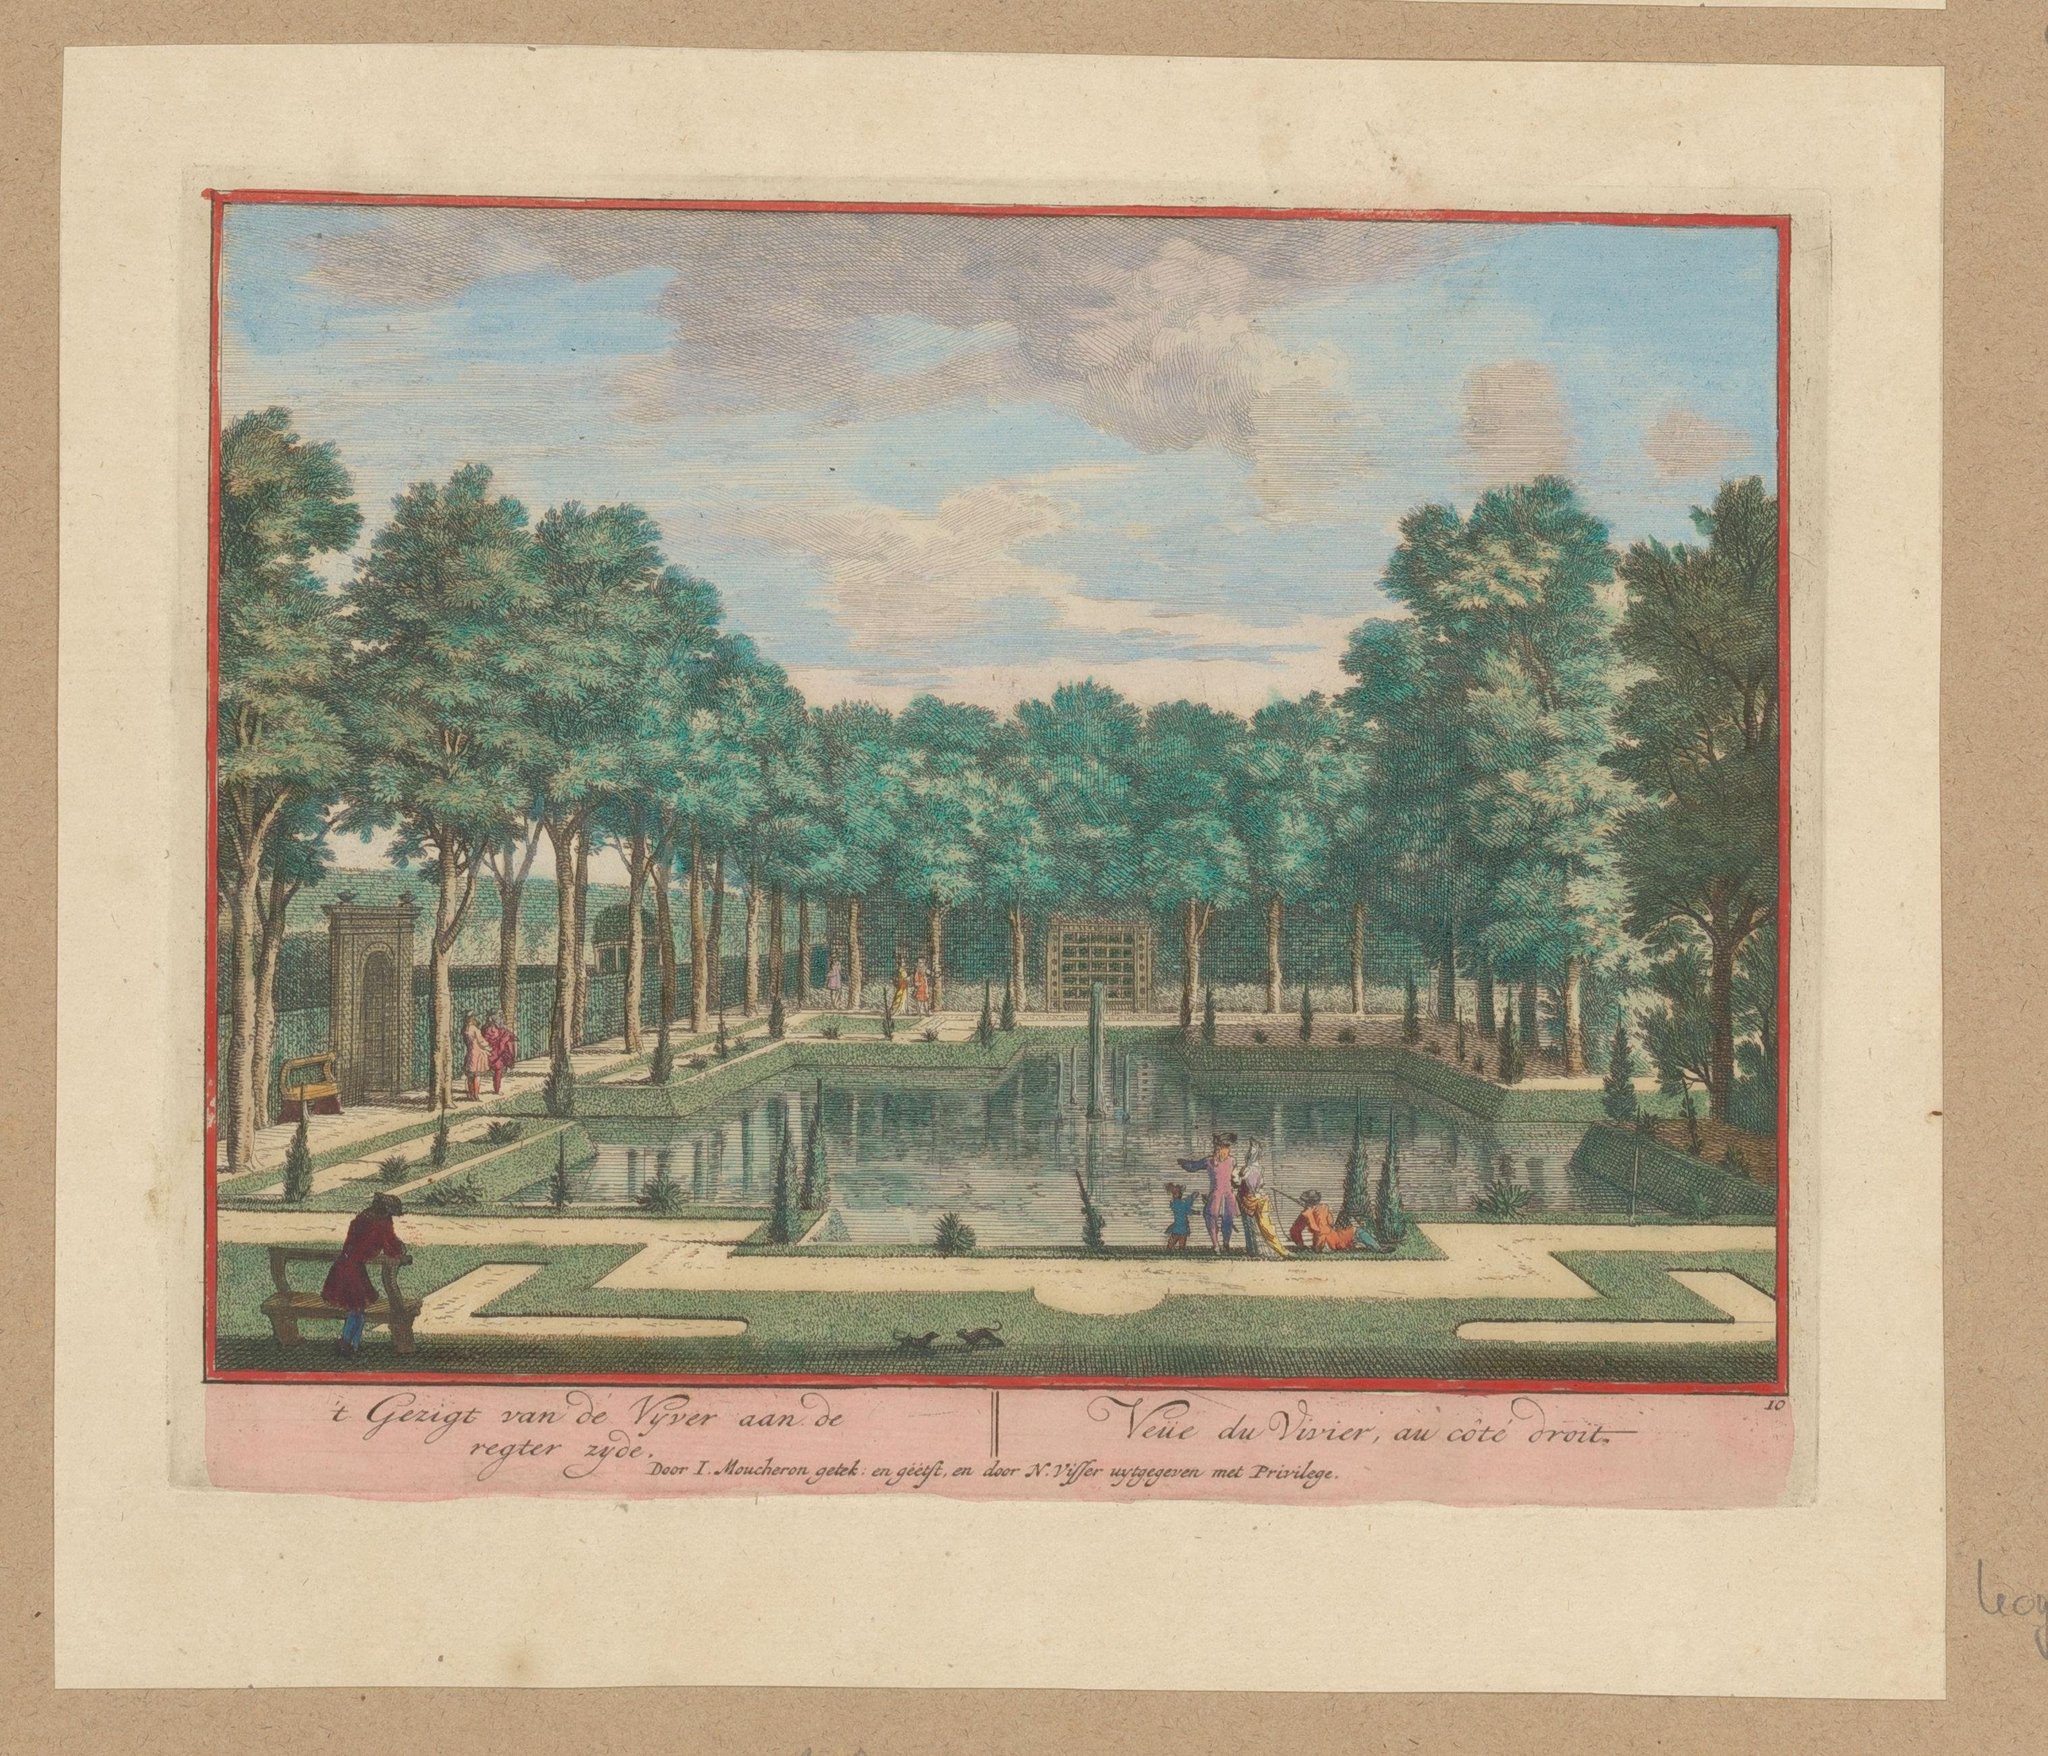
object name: print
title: Vijver bij Kasteel Heemstede gezien van rechts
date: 1706-1719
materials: paper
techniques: engraving, etching, hand coloring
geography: amsterdam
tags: french or architectonic garden; formal garden, garden pond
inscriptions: collector's mark: Lugt 1641, stamp, stamp, stamp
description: De vijver op het landgoed van Kasteel Heemstede gezien van rechts. Rechtsonder genummerd: 10. Onderwerpsrubrieken binnen de Atlas Zeden en Gewoonten: Zeden en Gewoonten in Engeren Zin, De Woning, Oude Nederlandsche Tuinkunst, De 17de en 18de eeuw. Stadtuinen.